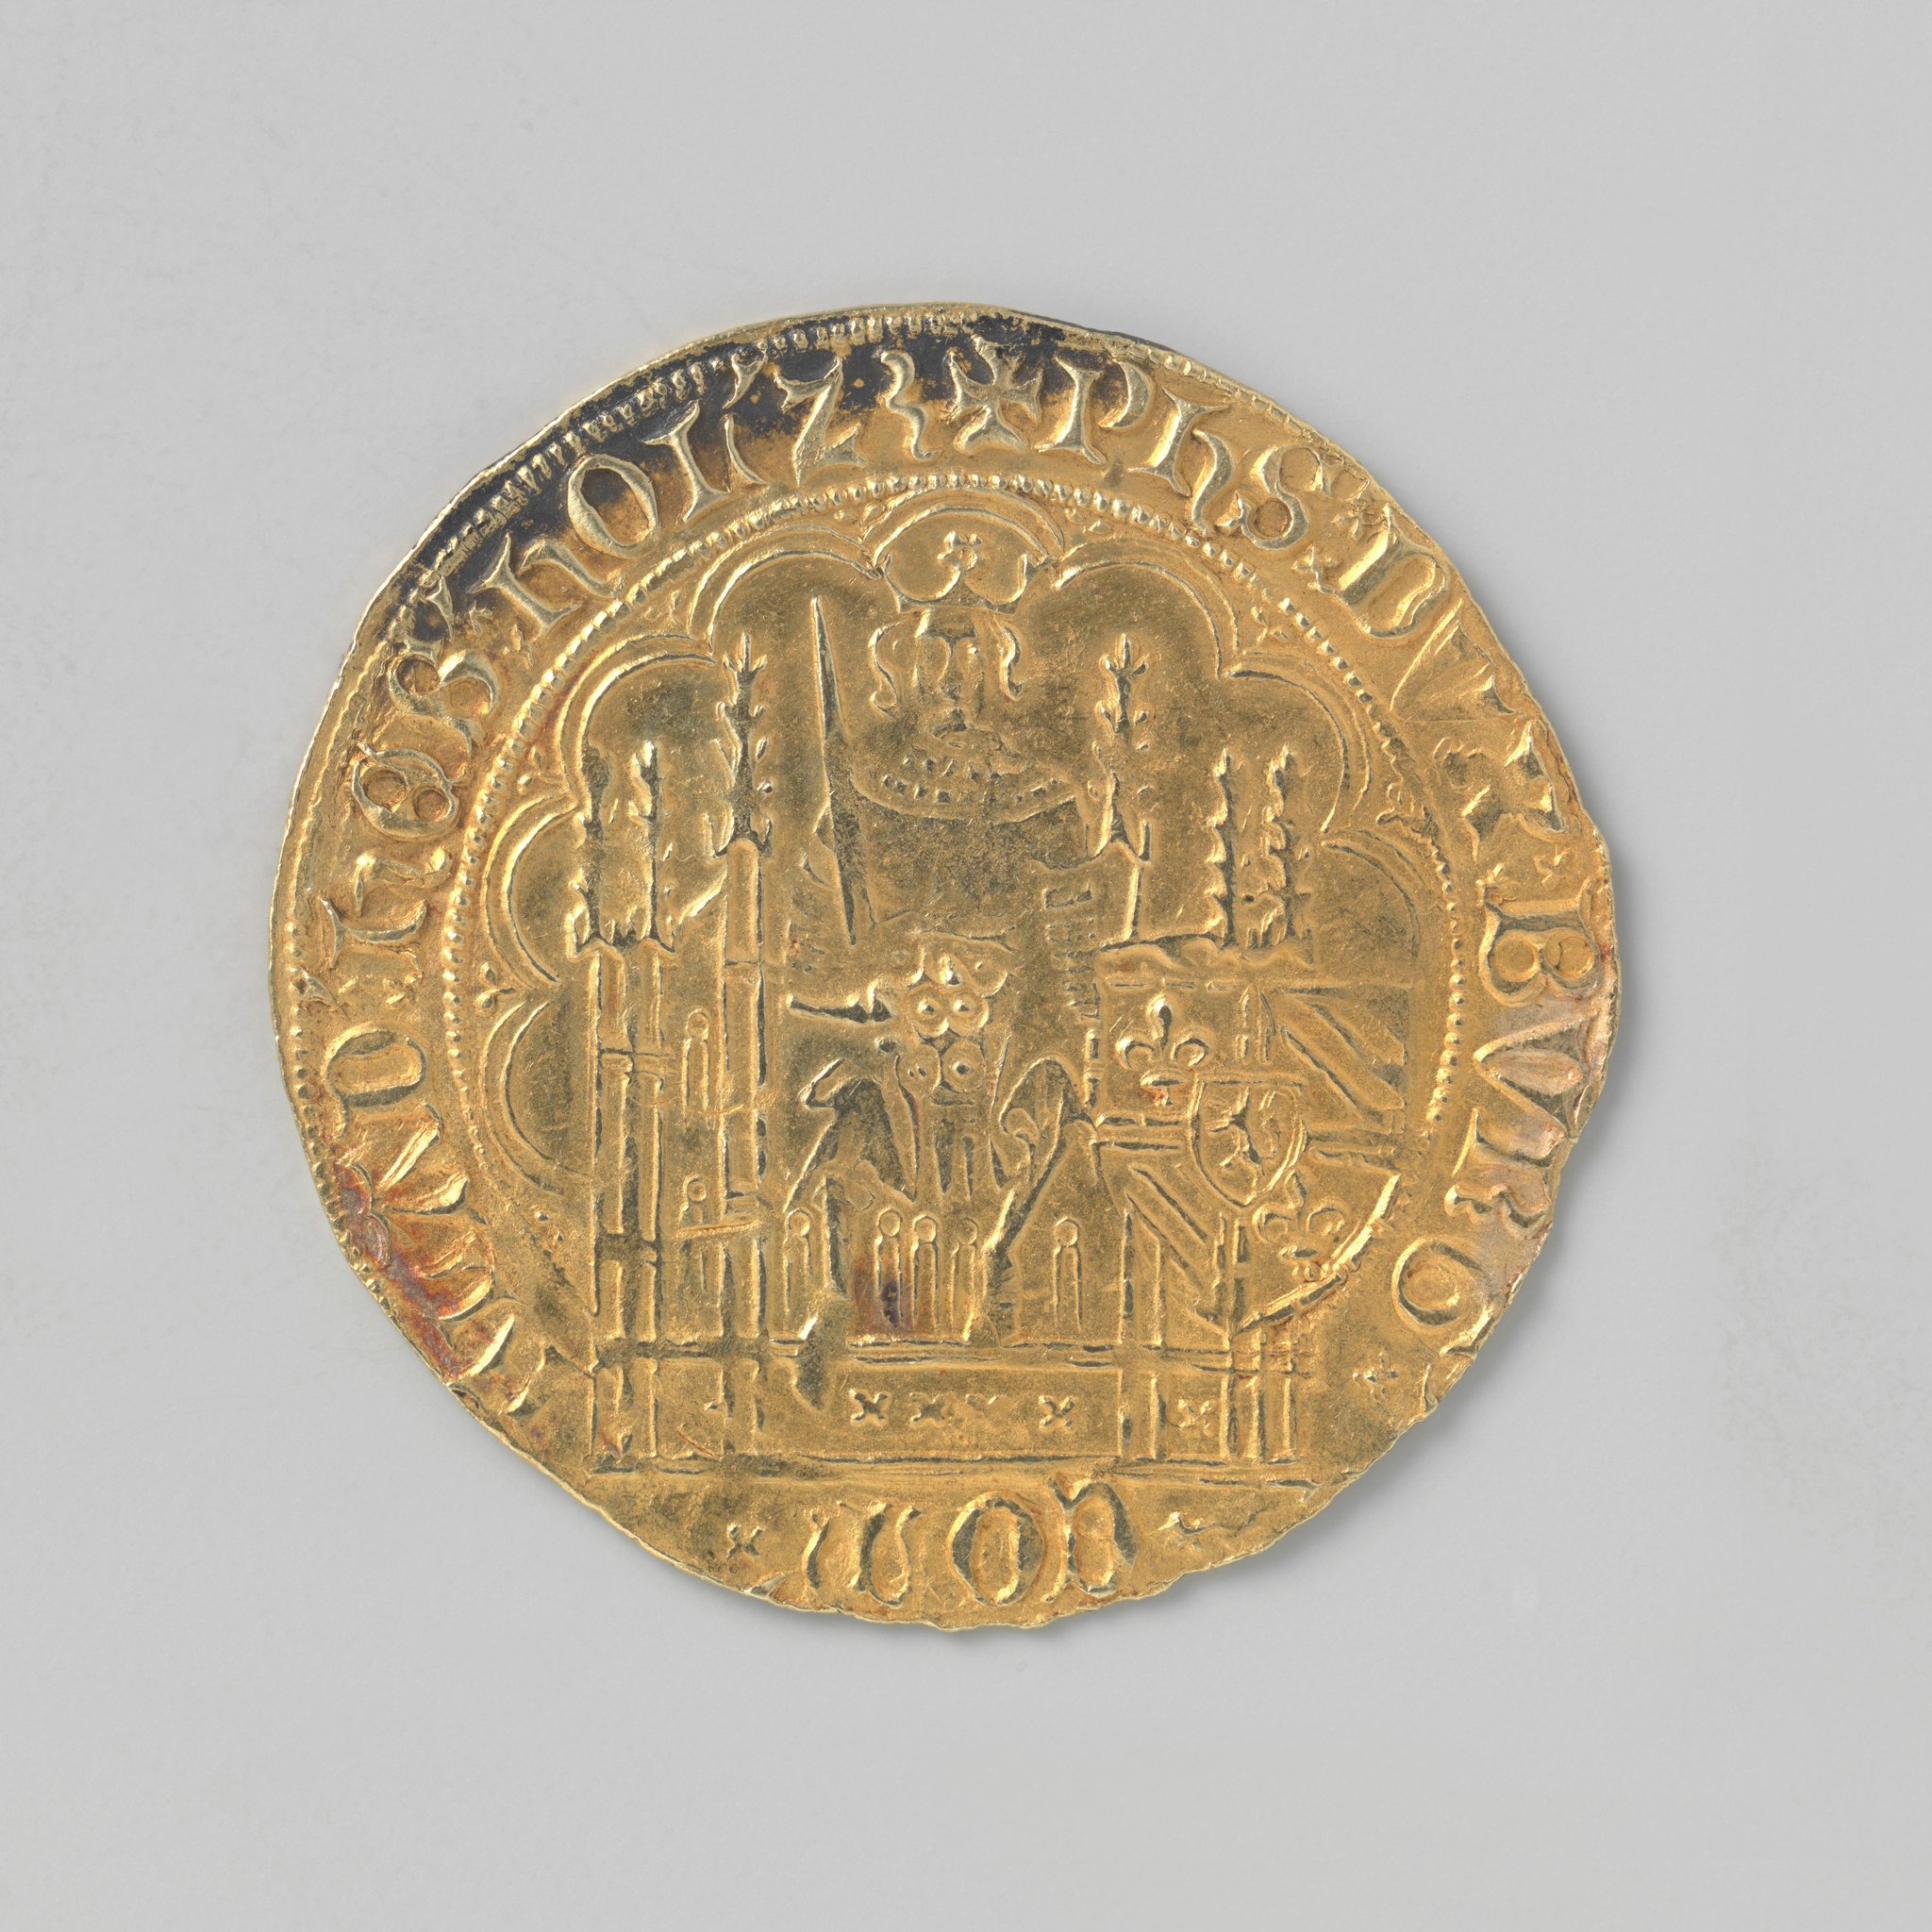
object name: coin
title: Hollands gouden schild van Philips de Goede, 1425-1428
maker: philip iii the good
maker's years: 1396-1467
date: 1425-1427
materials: gold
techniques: striking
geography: dordrecht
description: Gouden munt. Voorzijde: in veelpas gekroonde graaf op troon, in rechterhand zwaard, linkerhand rustend op wapenschild van Philips de Goede. Keerzijde: in vierpas kort versierd kruis.